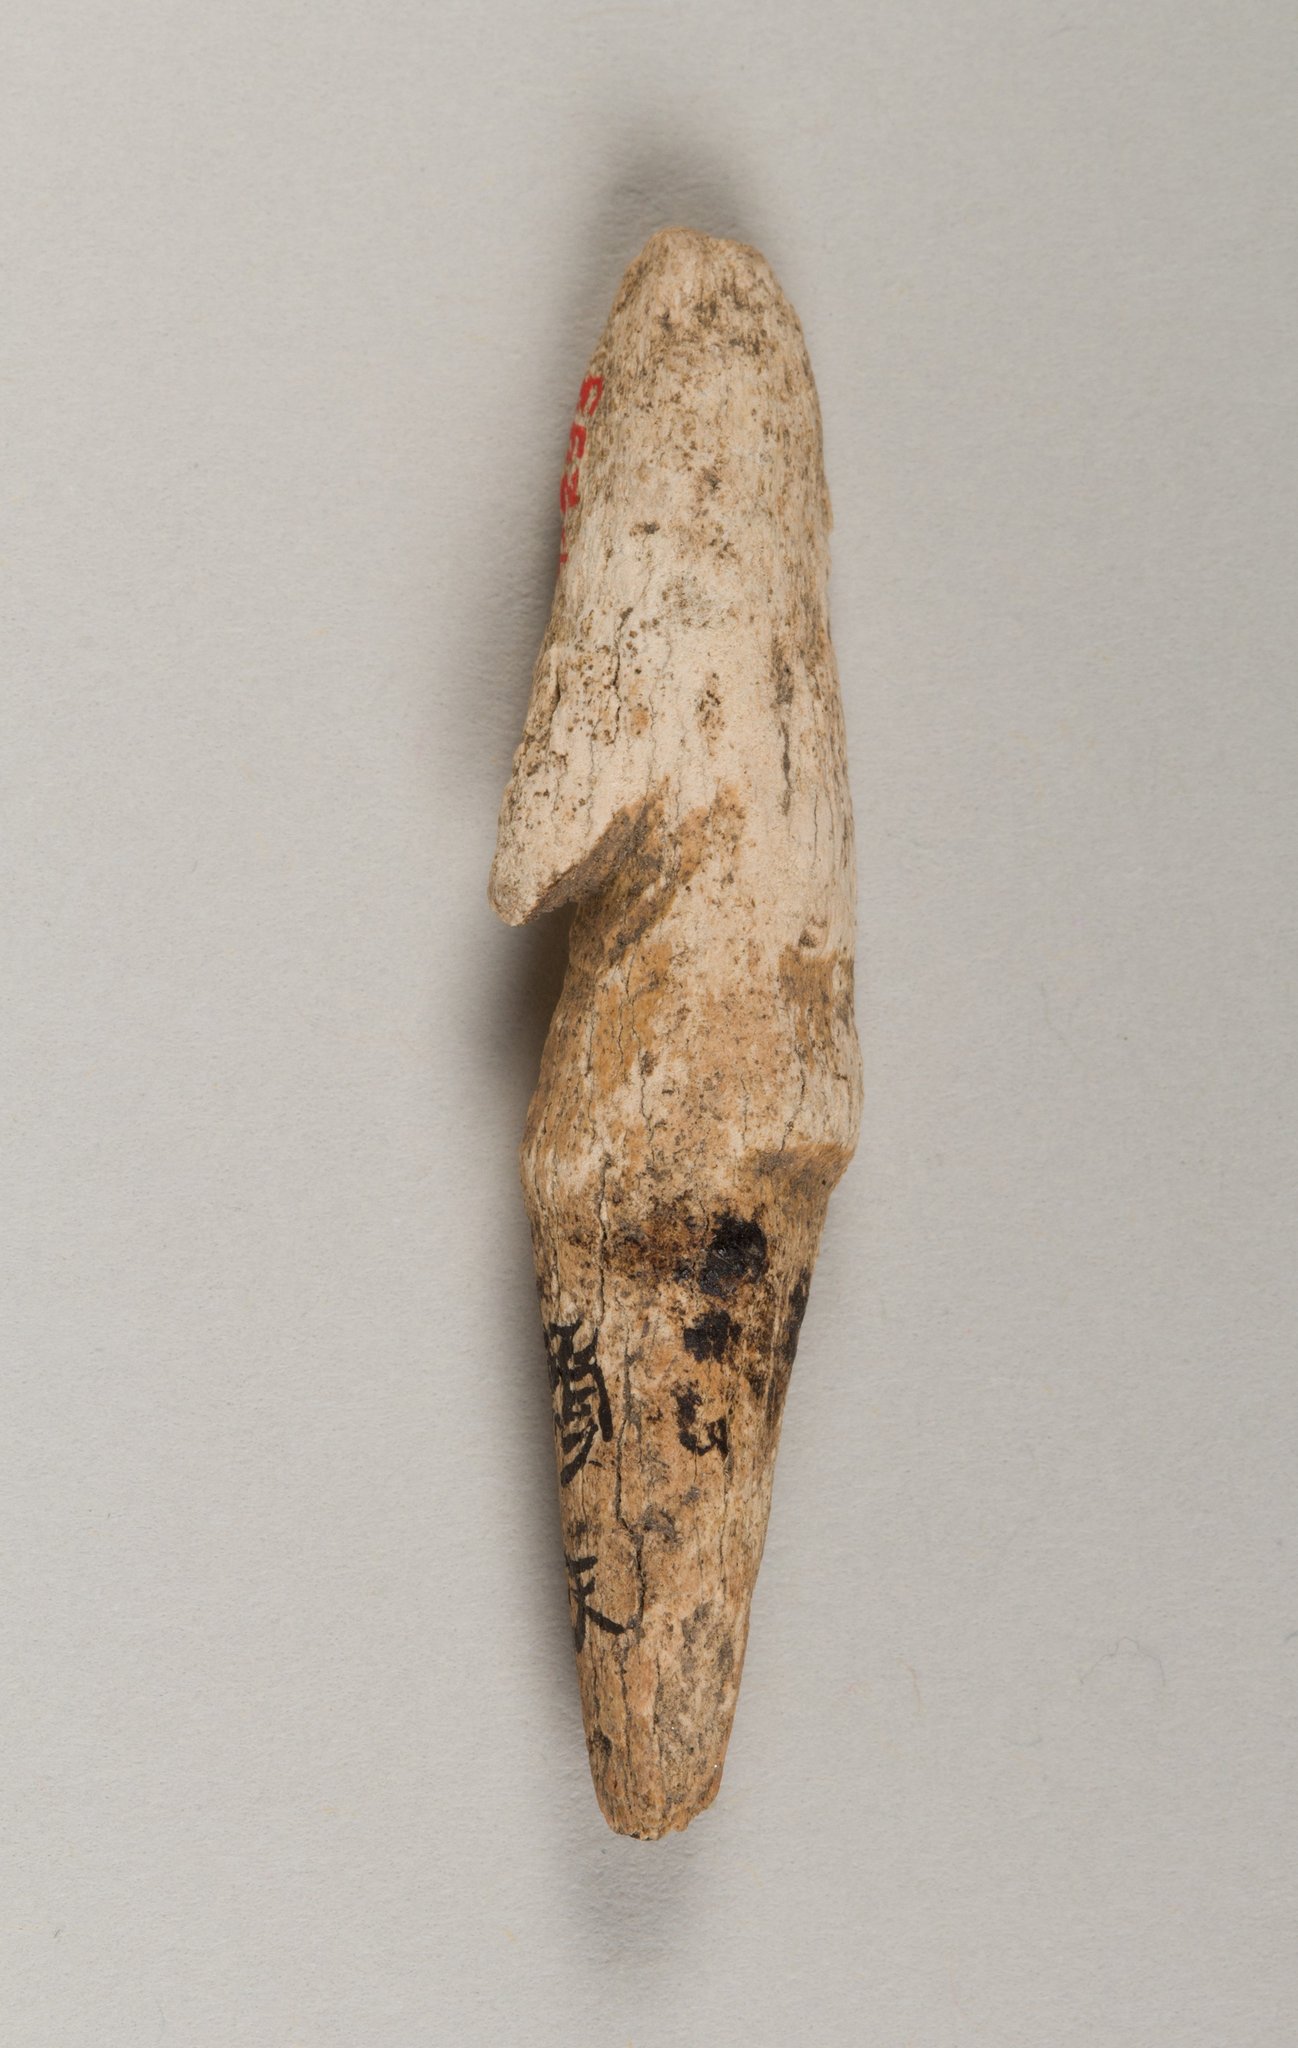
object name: harpoon head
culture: japanese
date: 1000-300 BCE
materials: bone